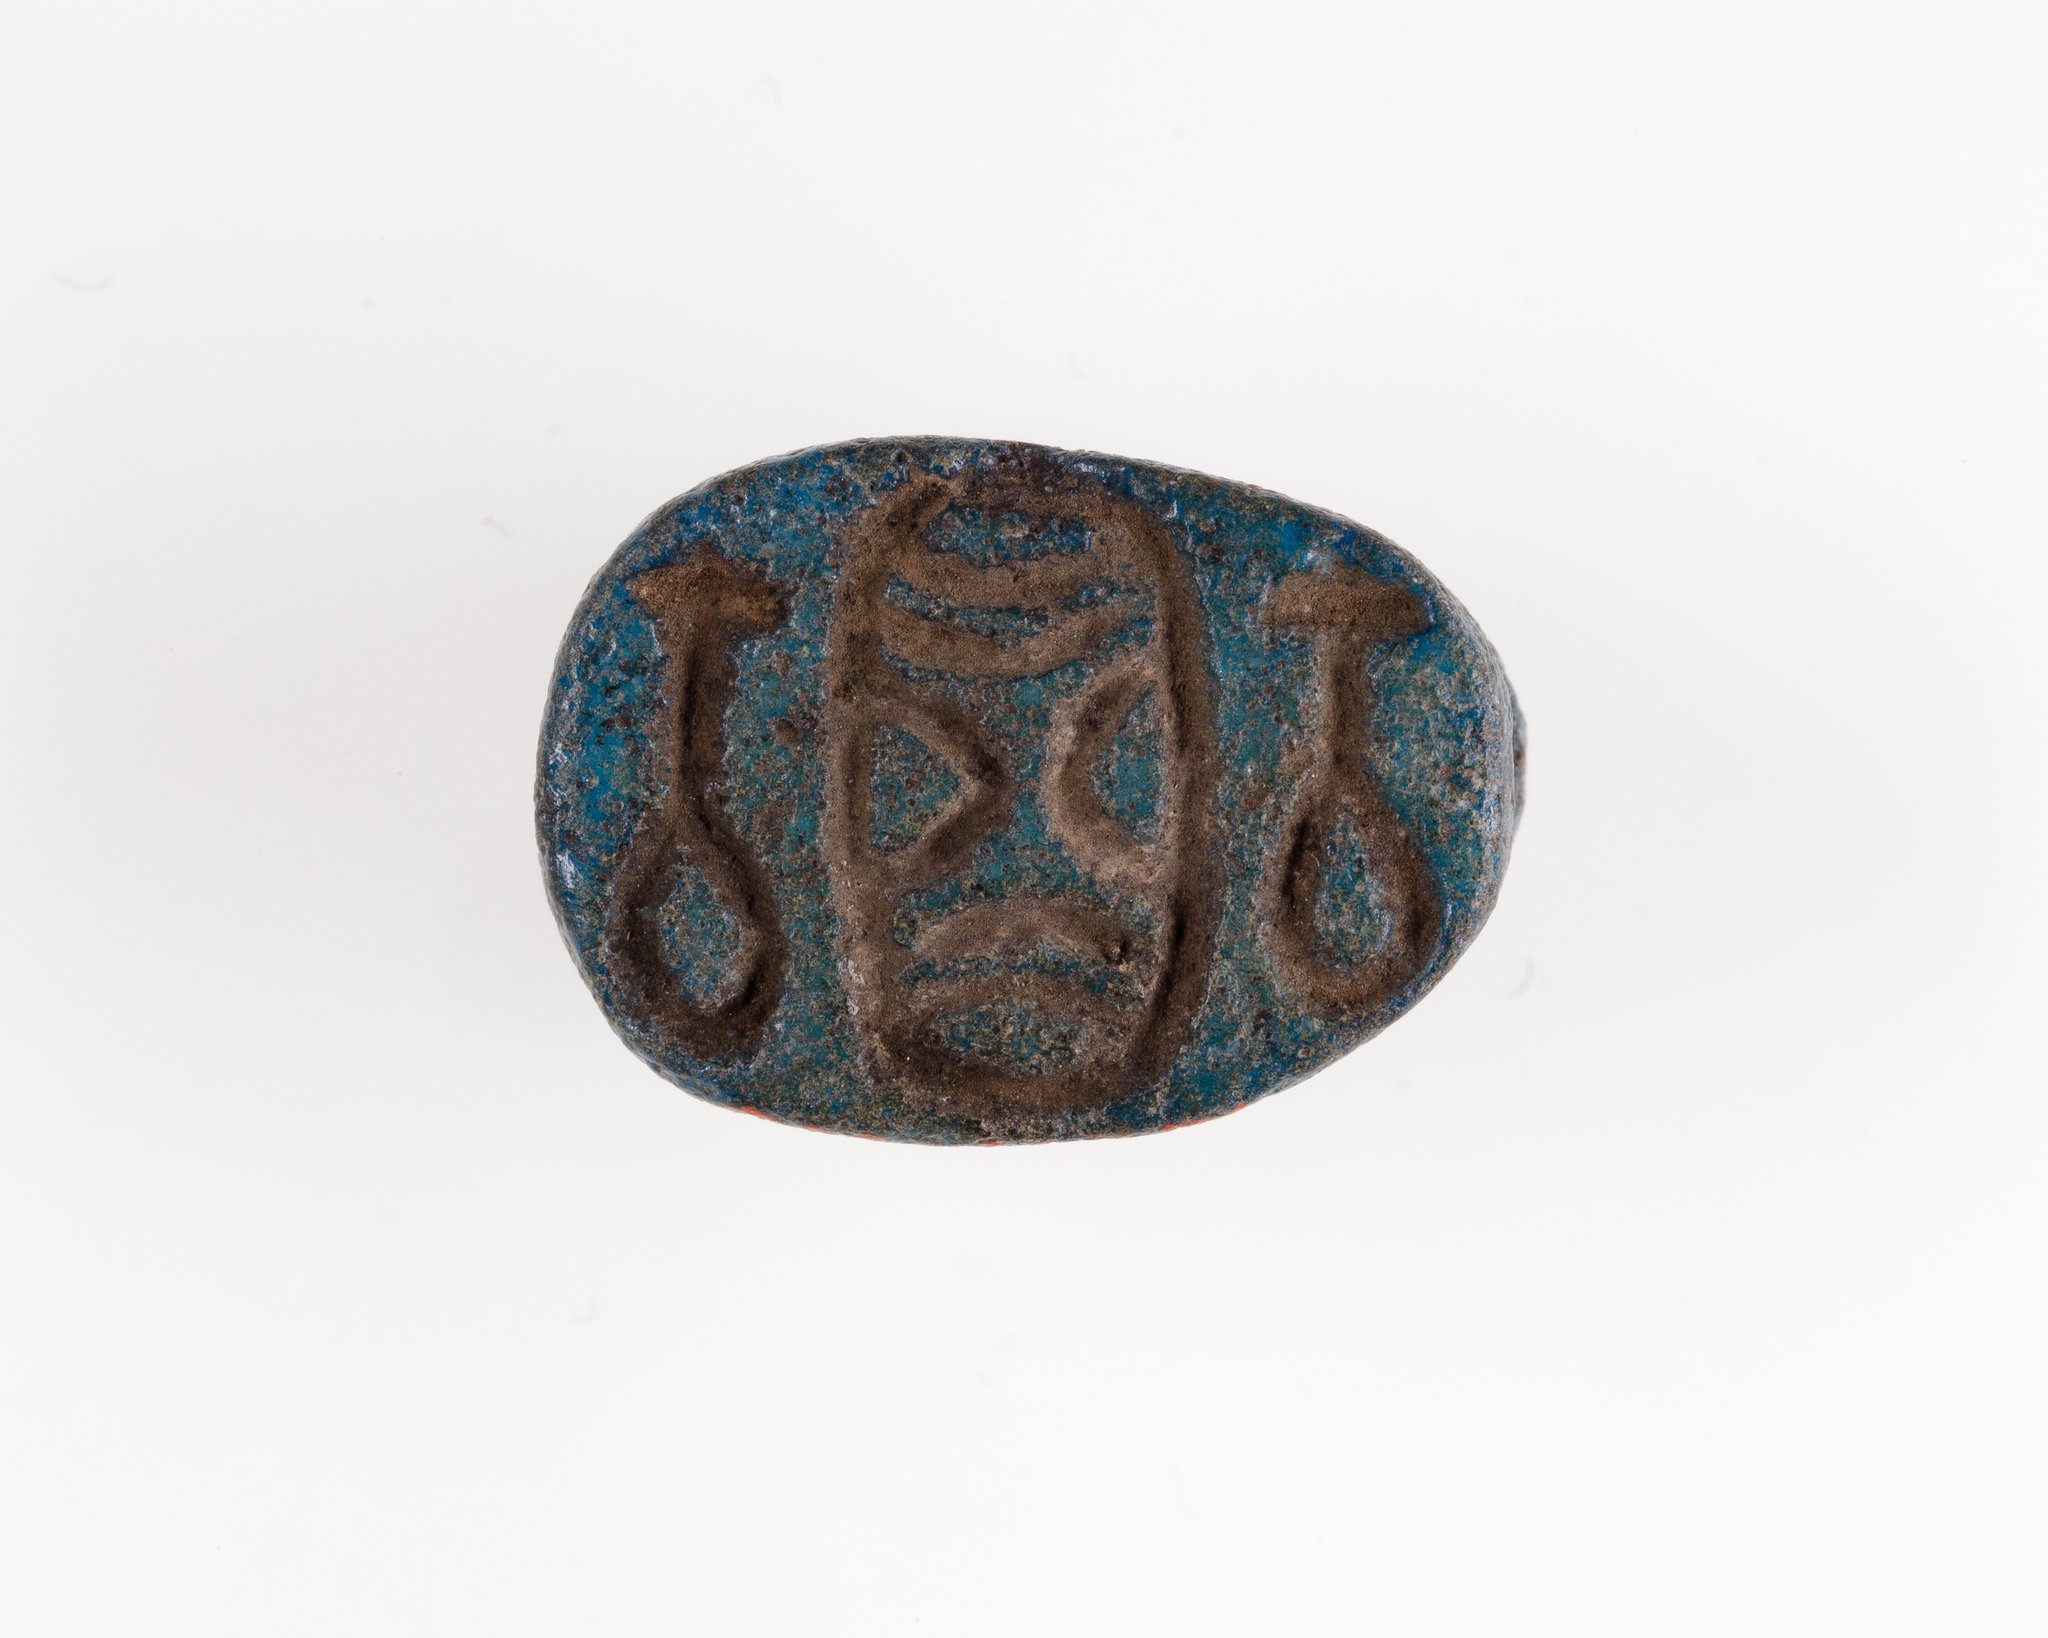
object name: scarab, geometric motif, oval, nefer hieroglyph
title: Scarab Incised with Hieroglyphs and Geometric Motif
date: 1802-1640 BCE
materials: faience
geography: egypt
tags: scarabs